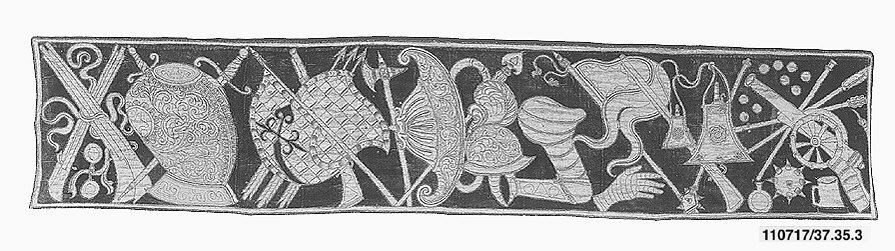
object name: hanging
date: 1550-1600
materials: metal thread, silk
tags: armor